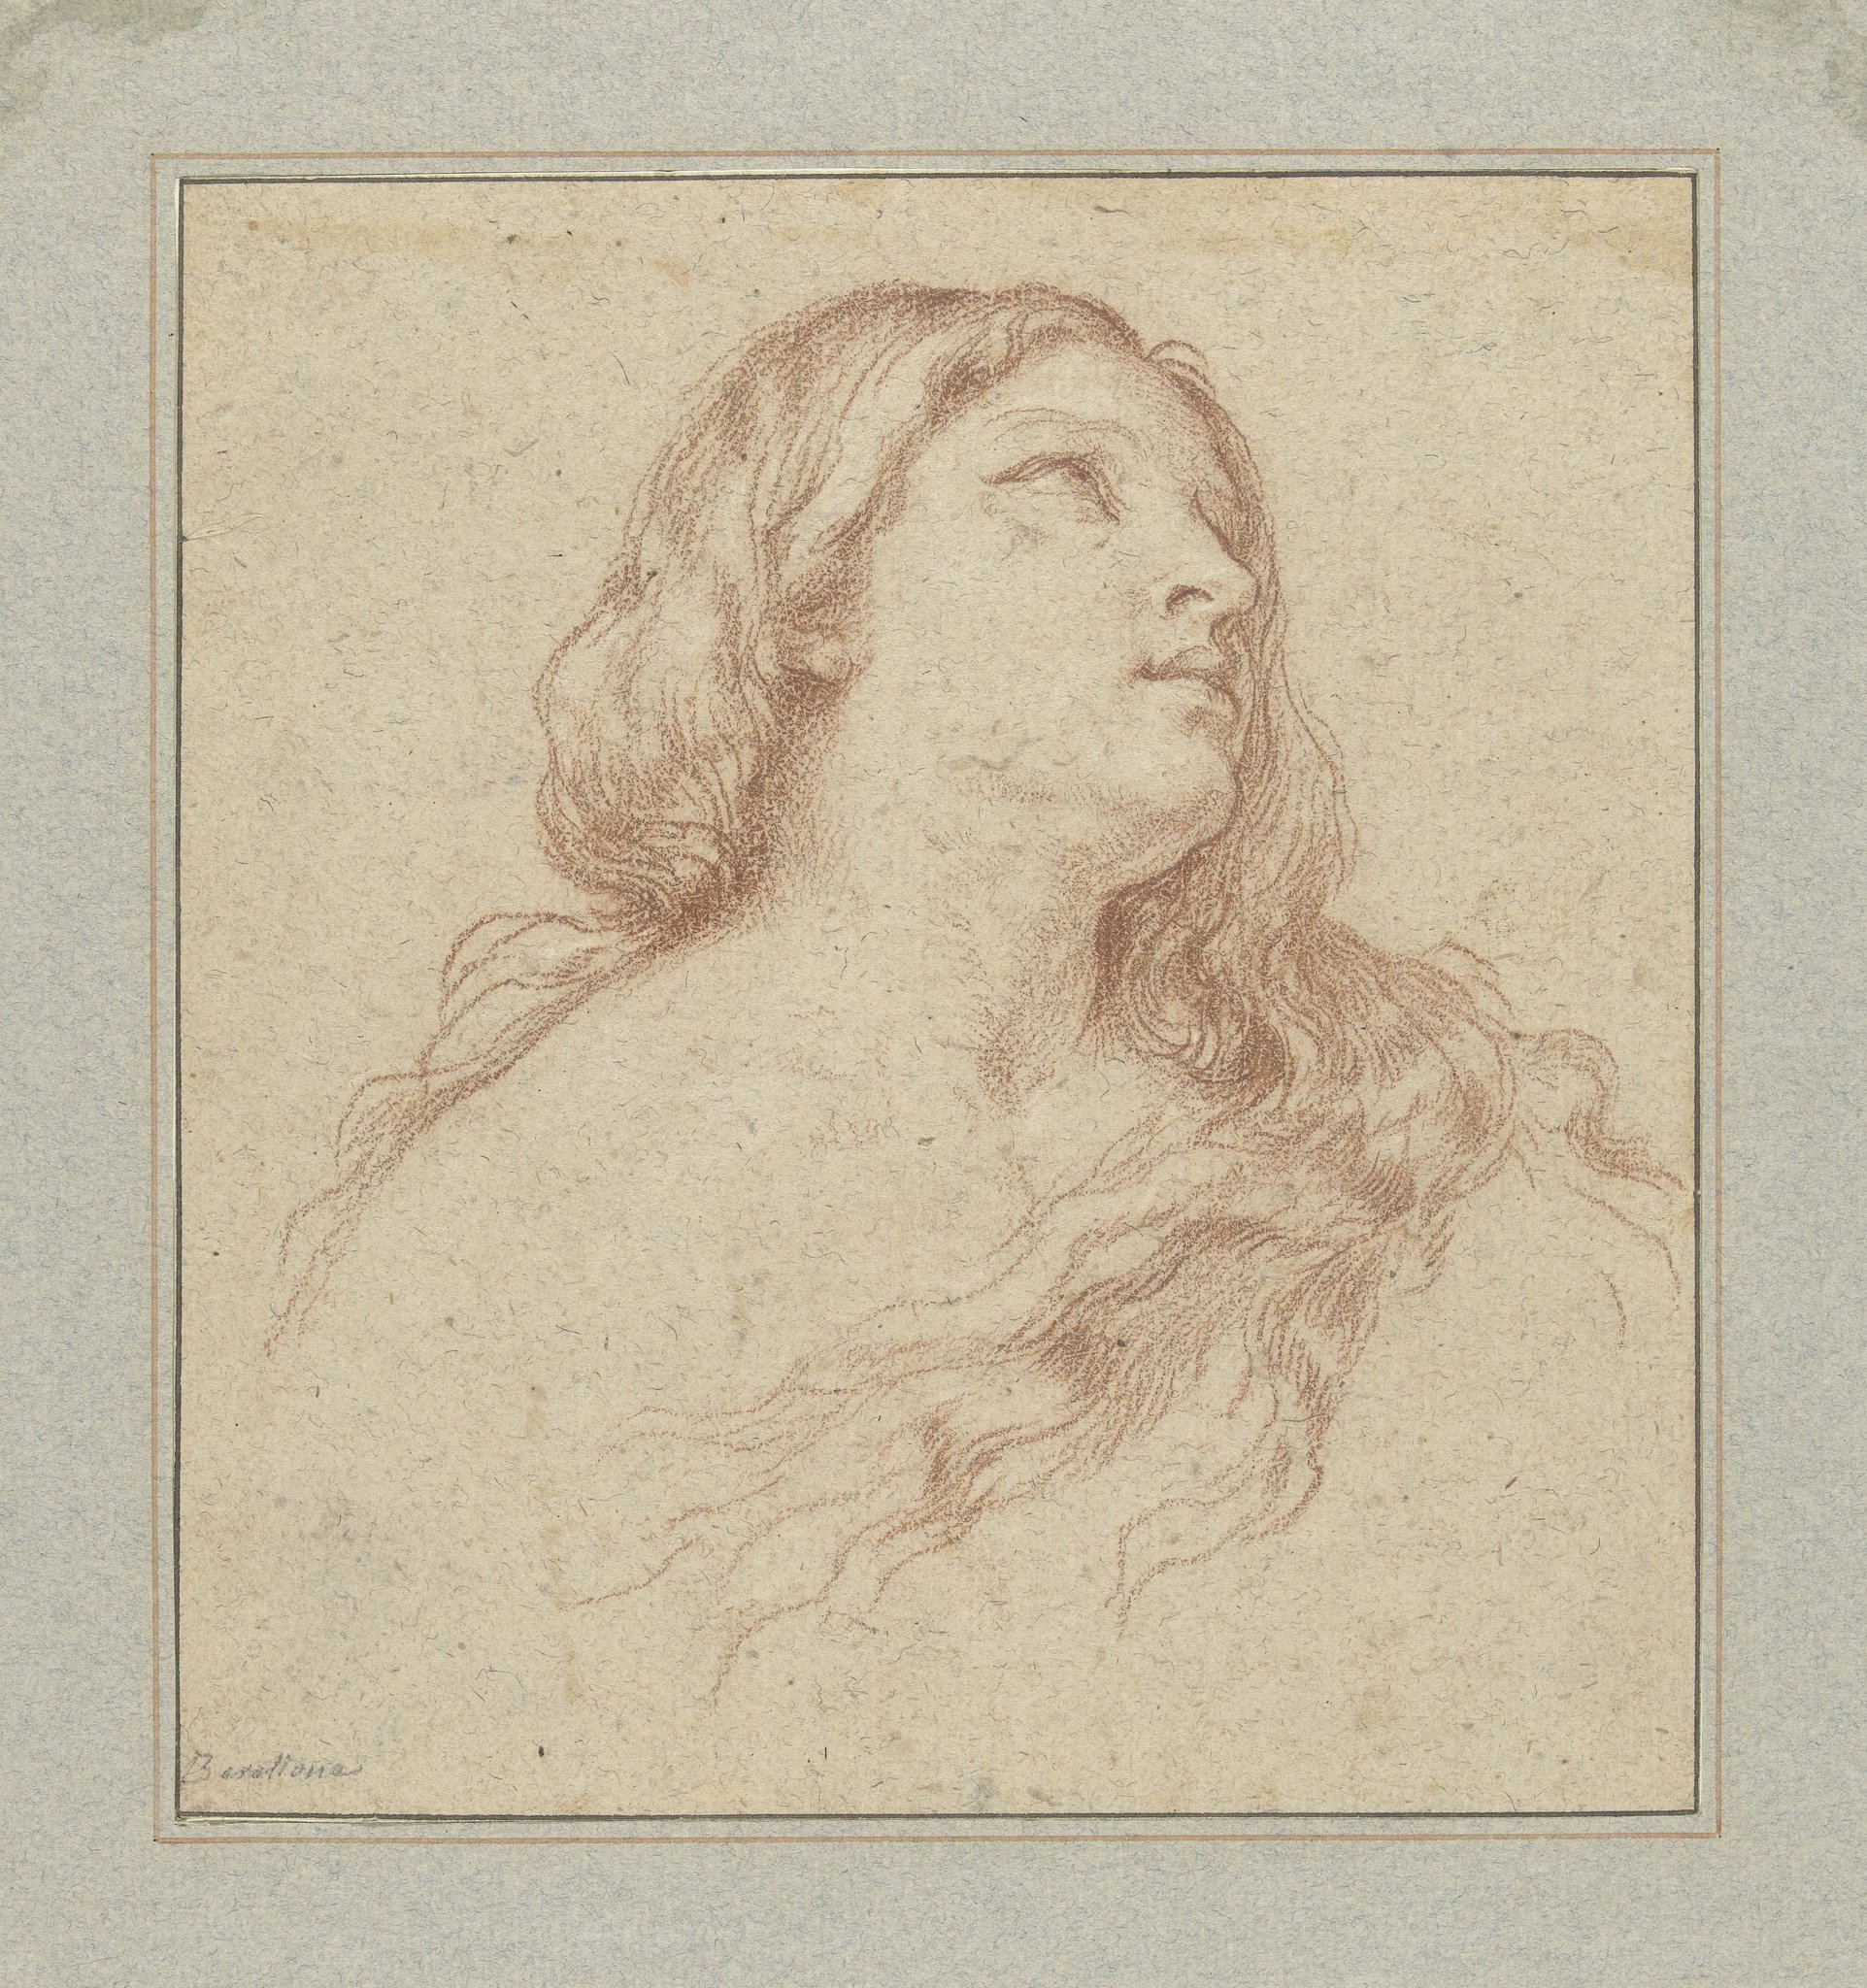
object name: drawing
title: Studie voor het hoofd van een Maria Magdalena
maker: niccolò berrettoni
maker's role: draughtsman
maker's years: 1637-1682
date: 1647-1682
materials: chalk, paper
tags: the penitent harlot mary magdalene; possible attributes: book (or scroll), crown, crown of thorns, crucifix, jar of ointment, mirror, musical instrument, palm-branch, rosary, scourge